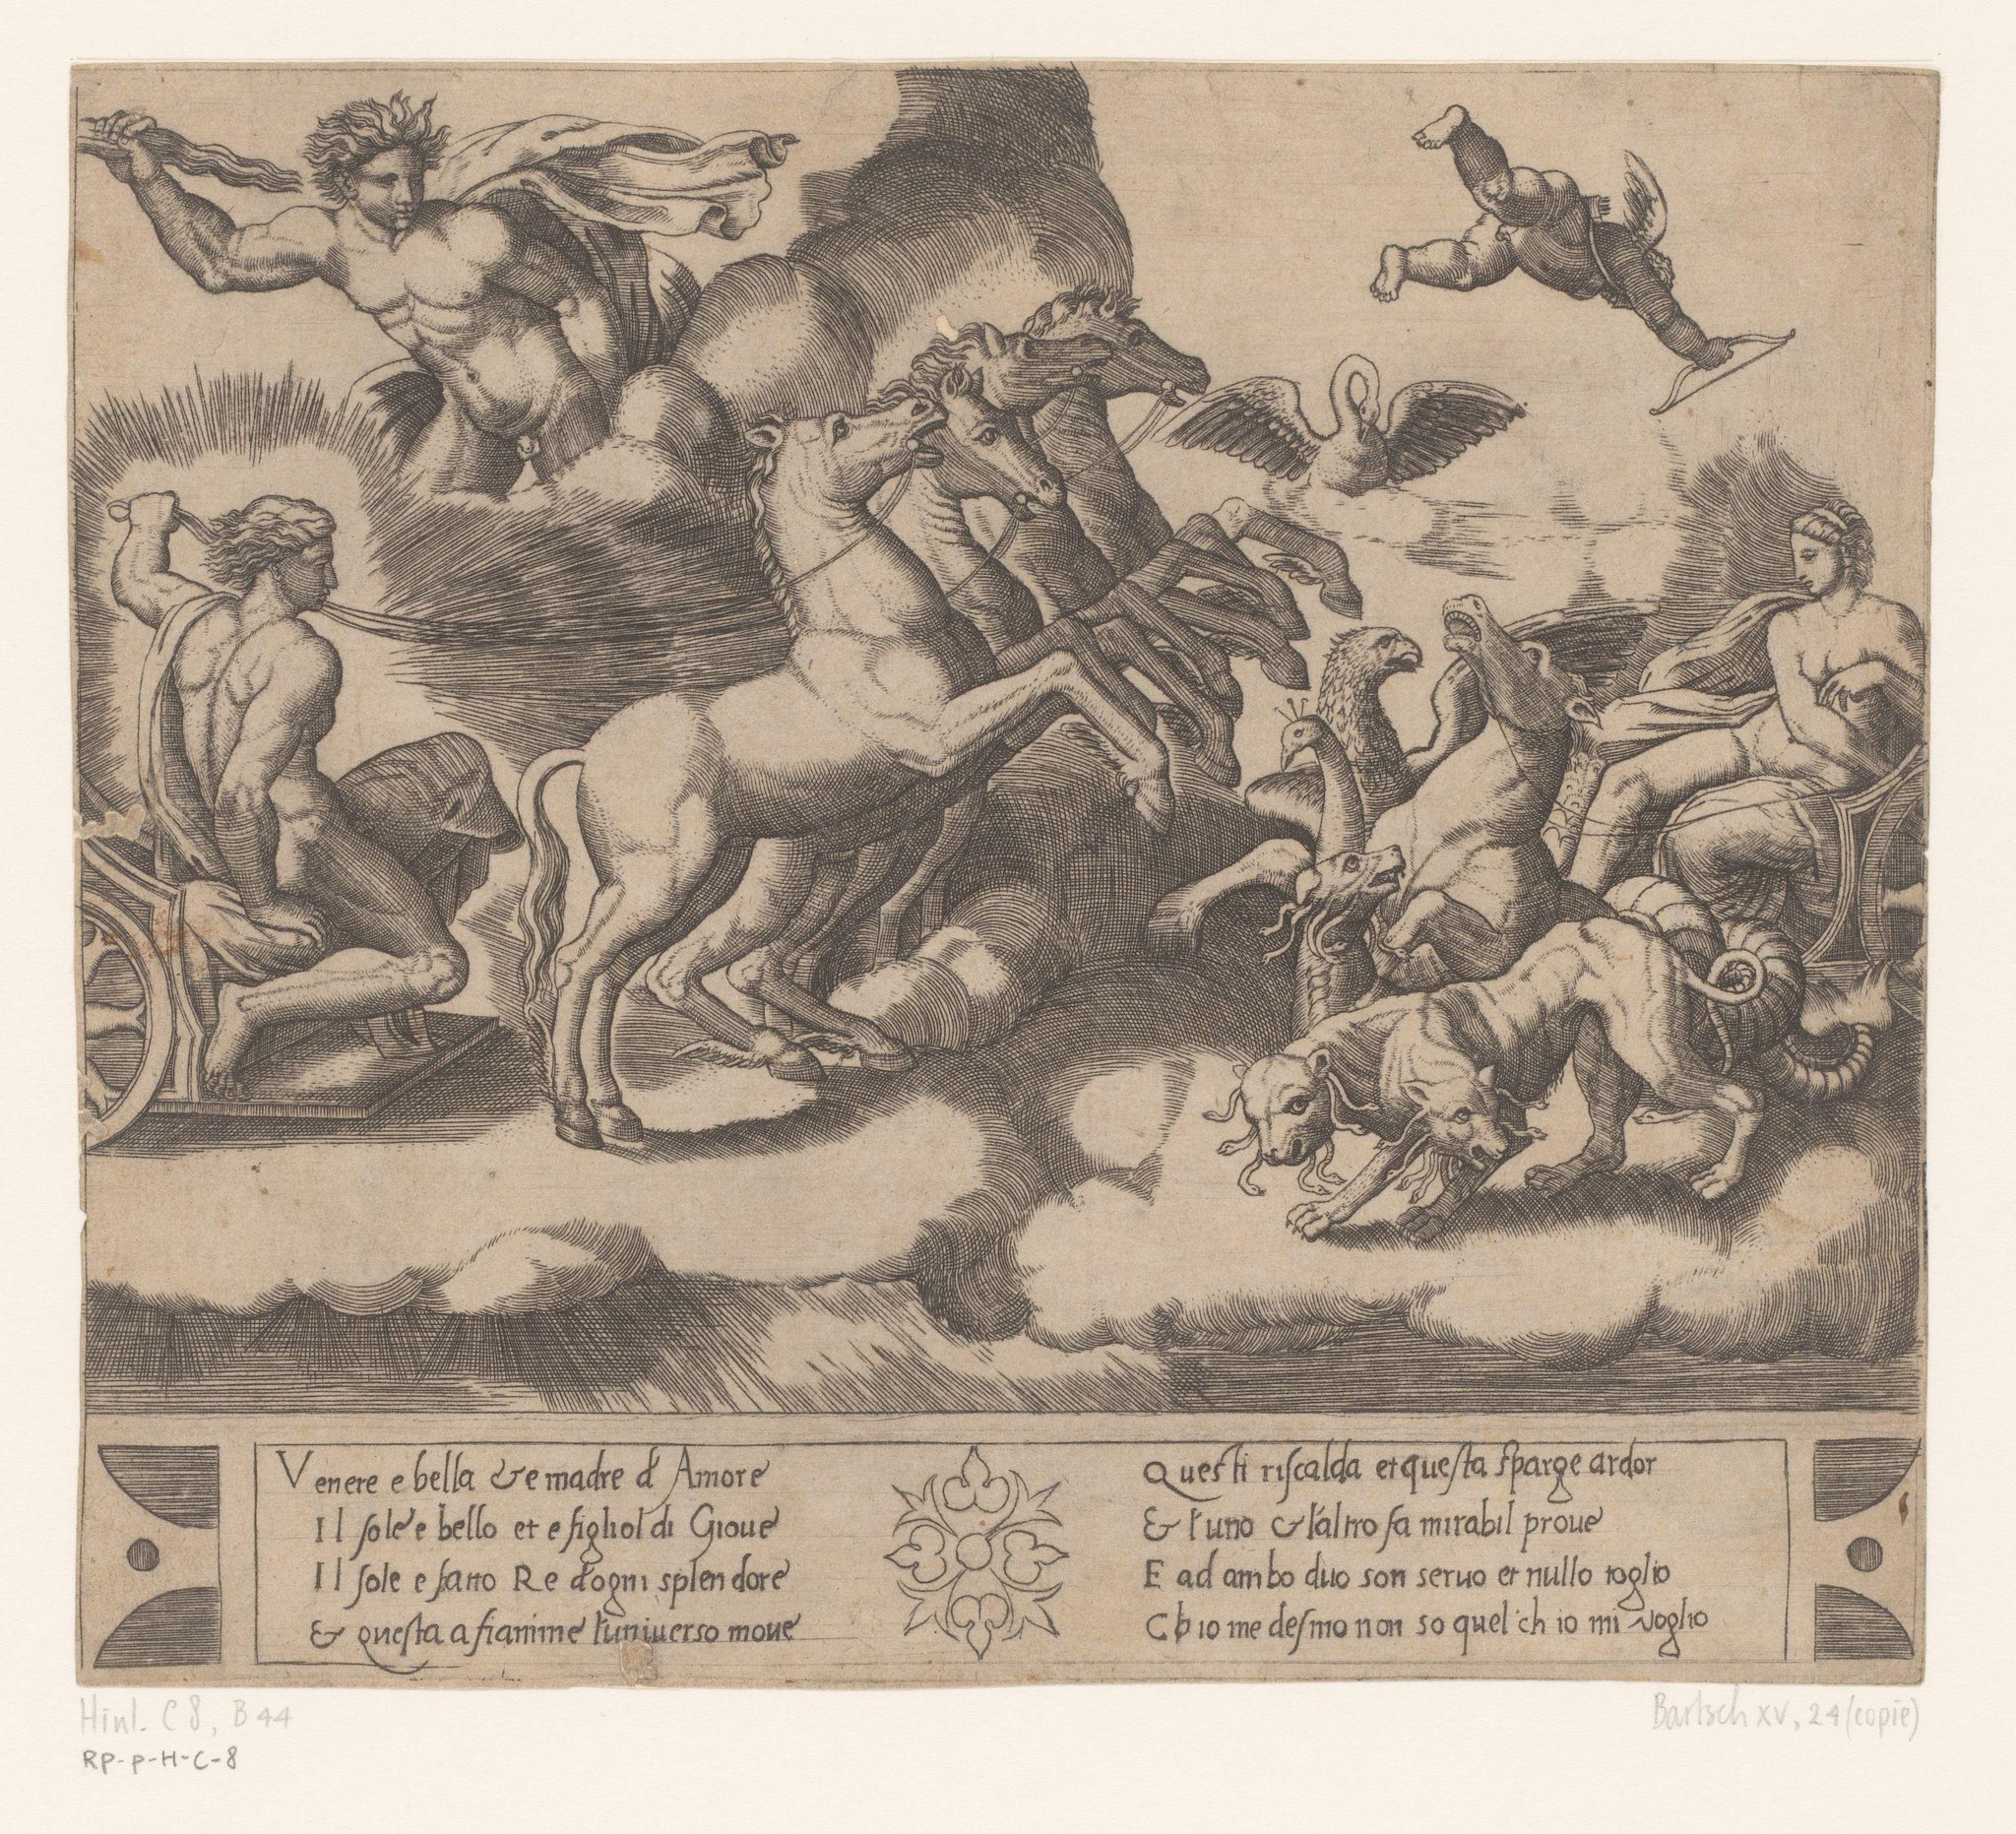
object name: print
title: Wagens van Venus en Apollo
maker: meester van de dobbelsteen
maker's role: print maker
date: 1530-1560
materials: paper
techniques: engraving, intaglio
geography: italy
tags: water-birds: swan, (story of) jupiter (zeus), (story of) cupid, amor (eros), apollo in the chariot of the sun, drawn by four horses, usually preceded by aurora holding a torch; 'carro del sole' (ripa), (story of) venus (aphrodite), roman chariot, quadriga ~ triumph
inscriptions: collector's mark: ‘Hinloopen’, collector's mark: Lugt 11, number: ‘1’, collector's mark: Lugt 10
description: Links Apollo op zijn wagen met vier naast elkaar aangespannen paarden. Rechts wordt de wagen van Venus getrokken door een adelaar, een pauw, een zeepaard en de driekoppige hond Cerberus met slangenstaart. Linksboven Jupiter met bliksemschicht en rechtsboven een zwaan en Amor met zijn boog. Italiaanse tekst in twee kolommen in ondermarge.